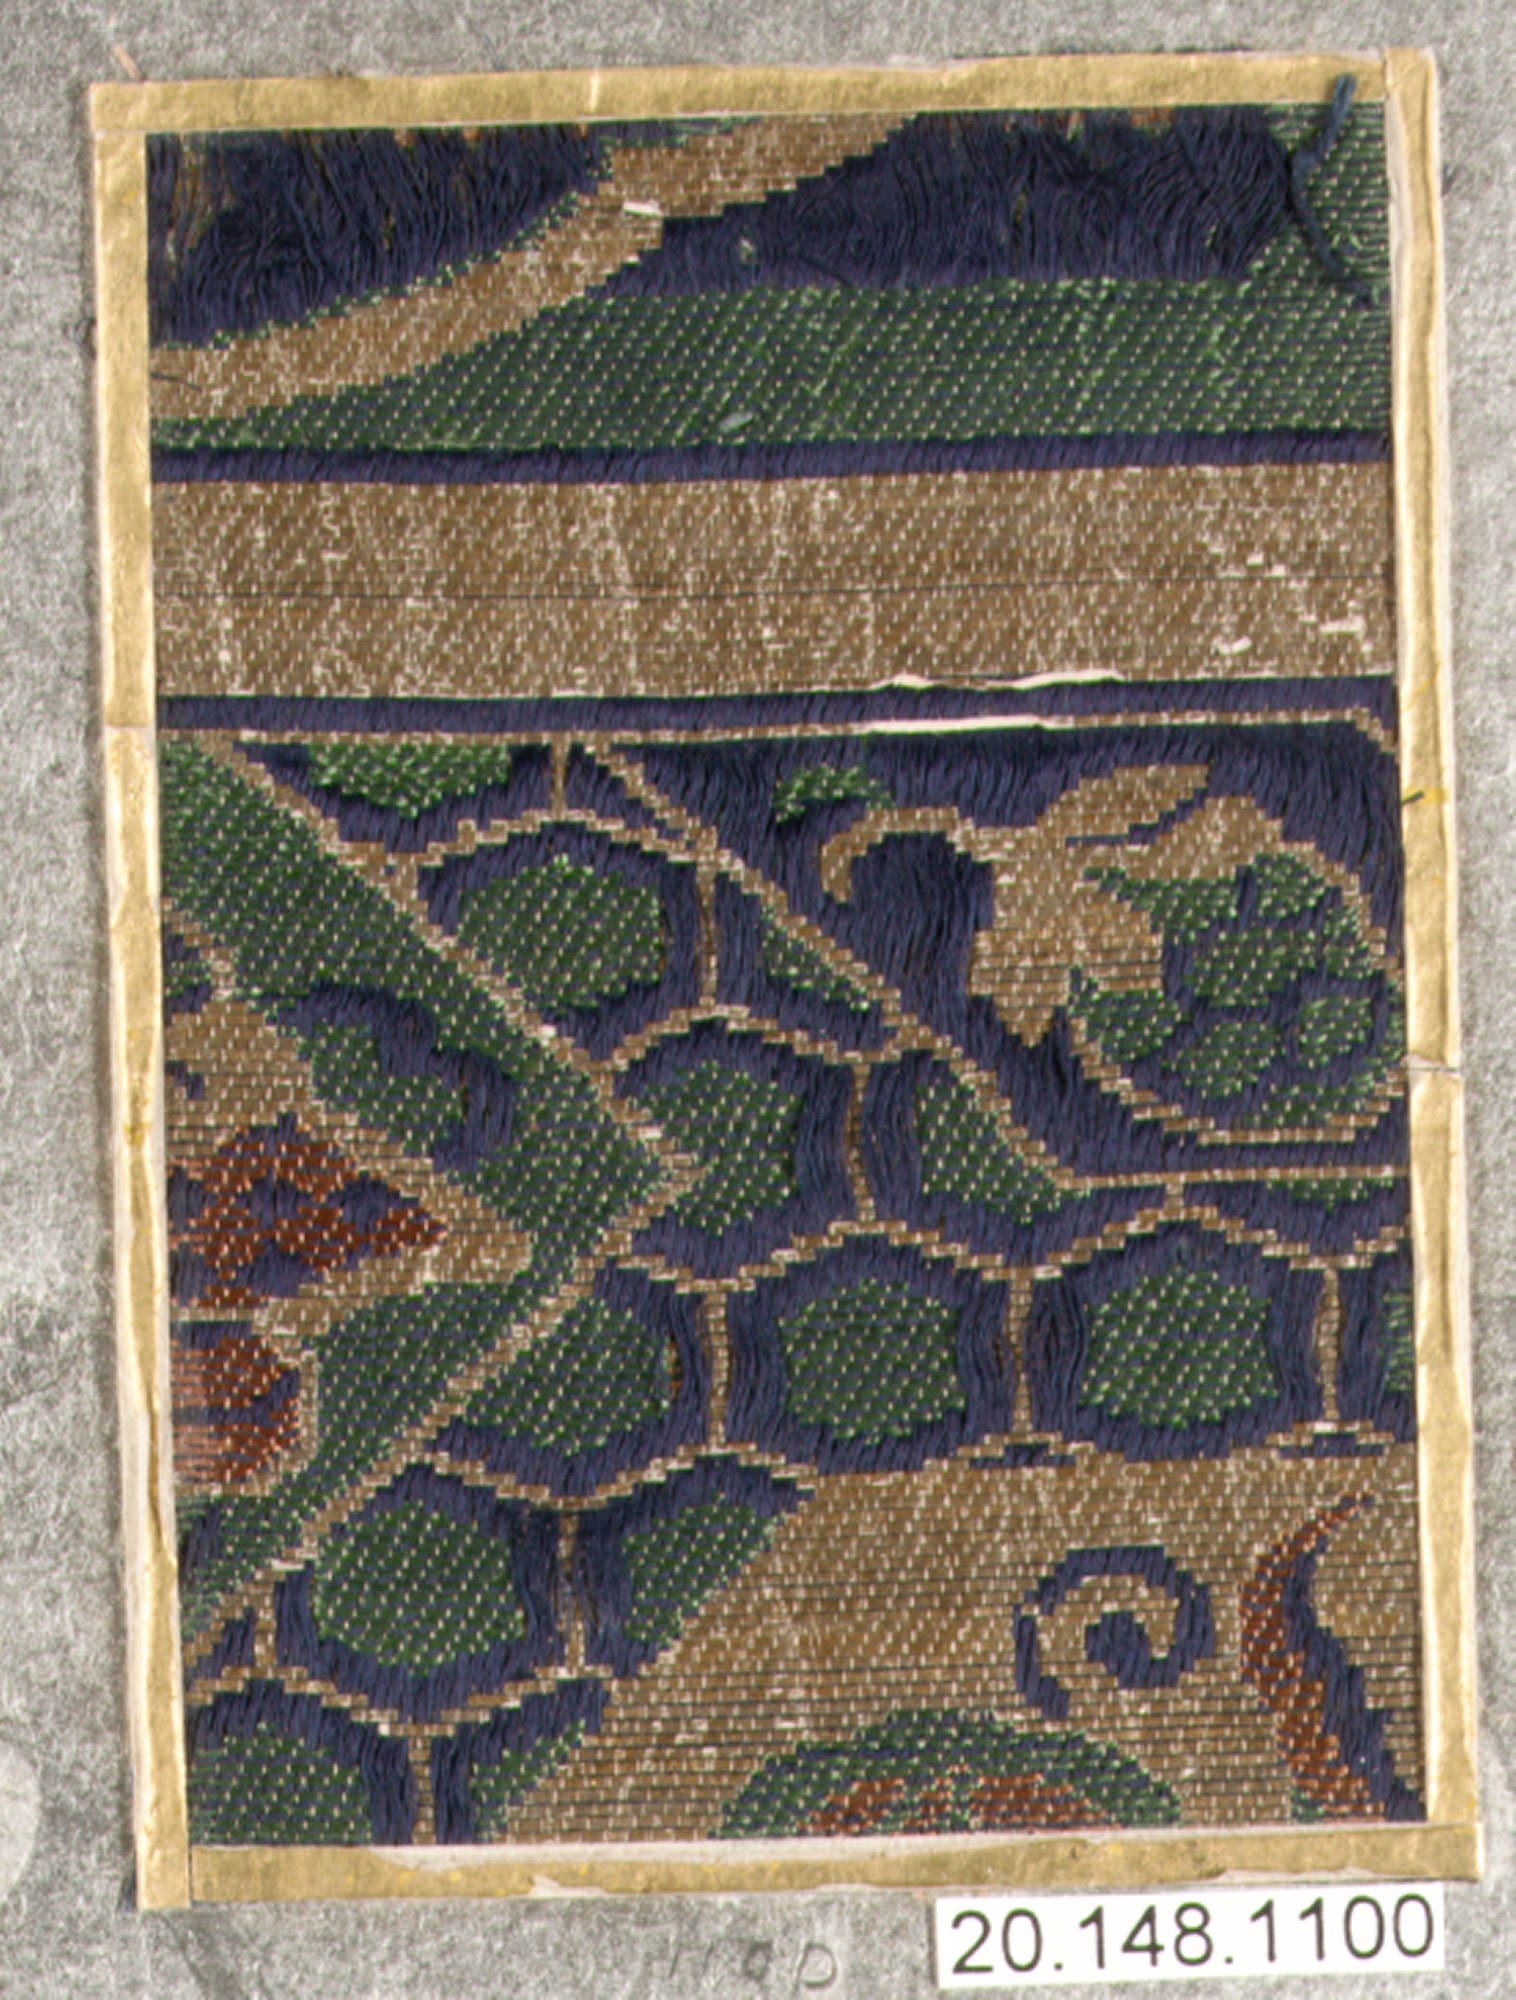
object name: piece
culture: china or japan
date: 1801-1900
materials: silk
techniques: compound weave